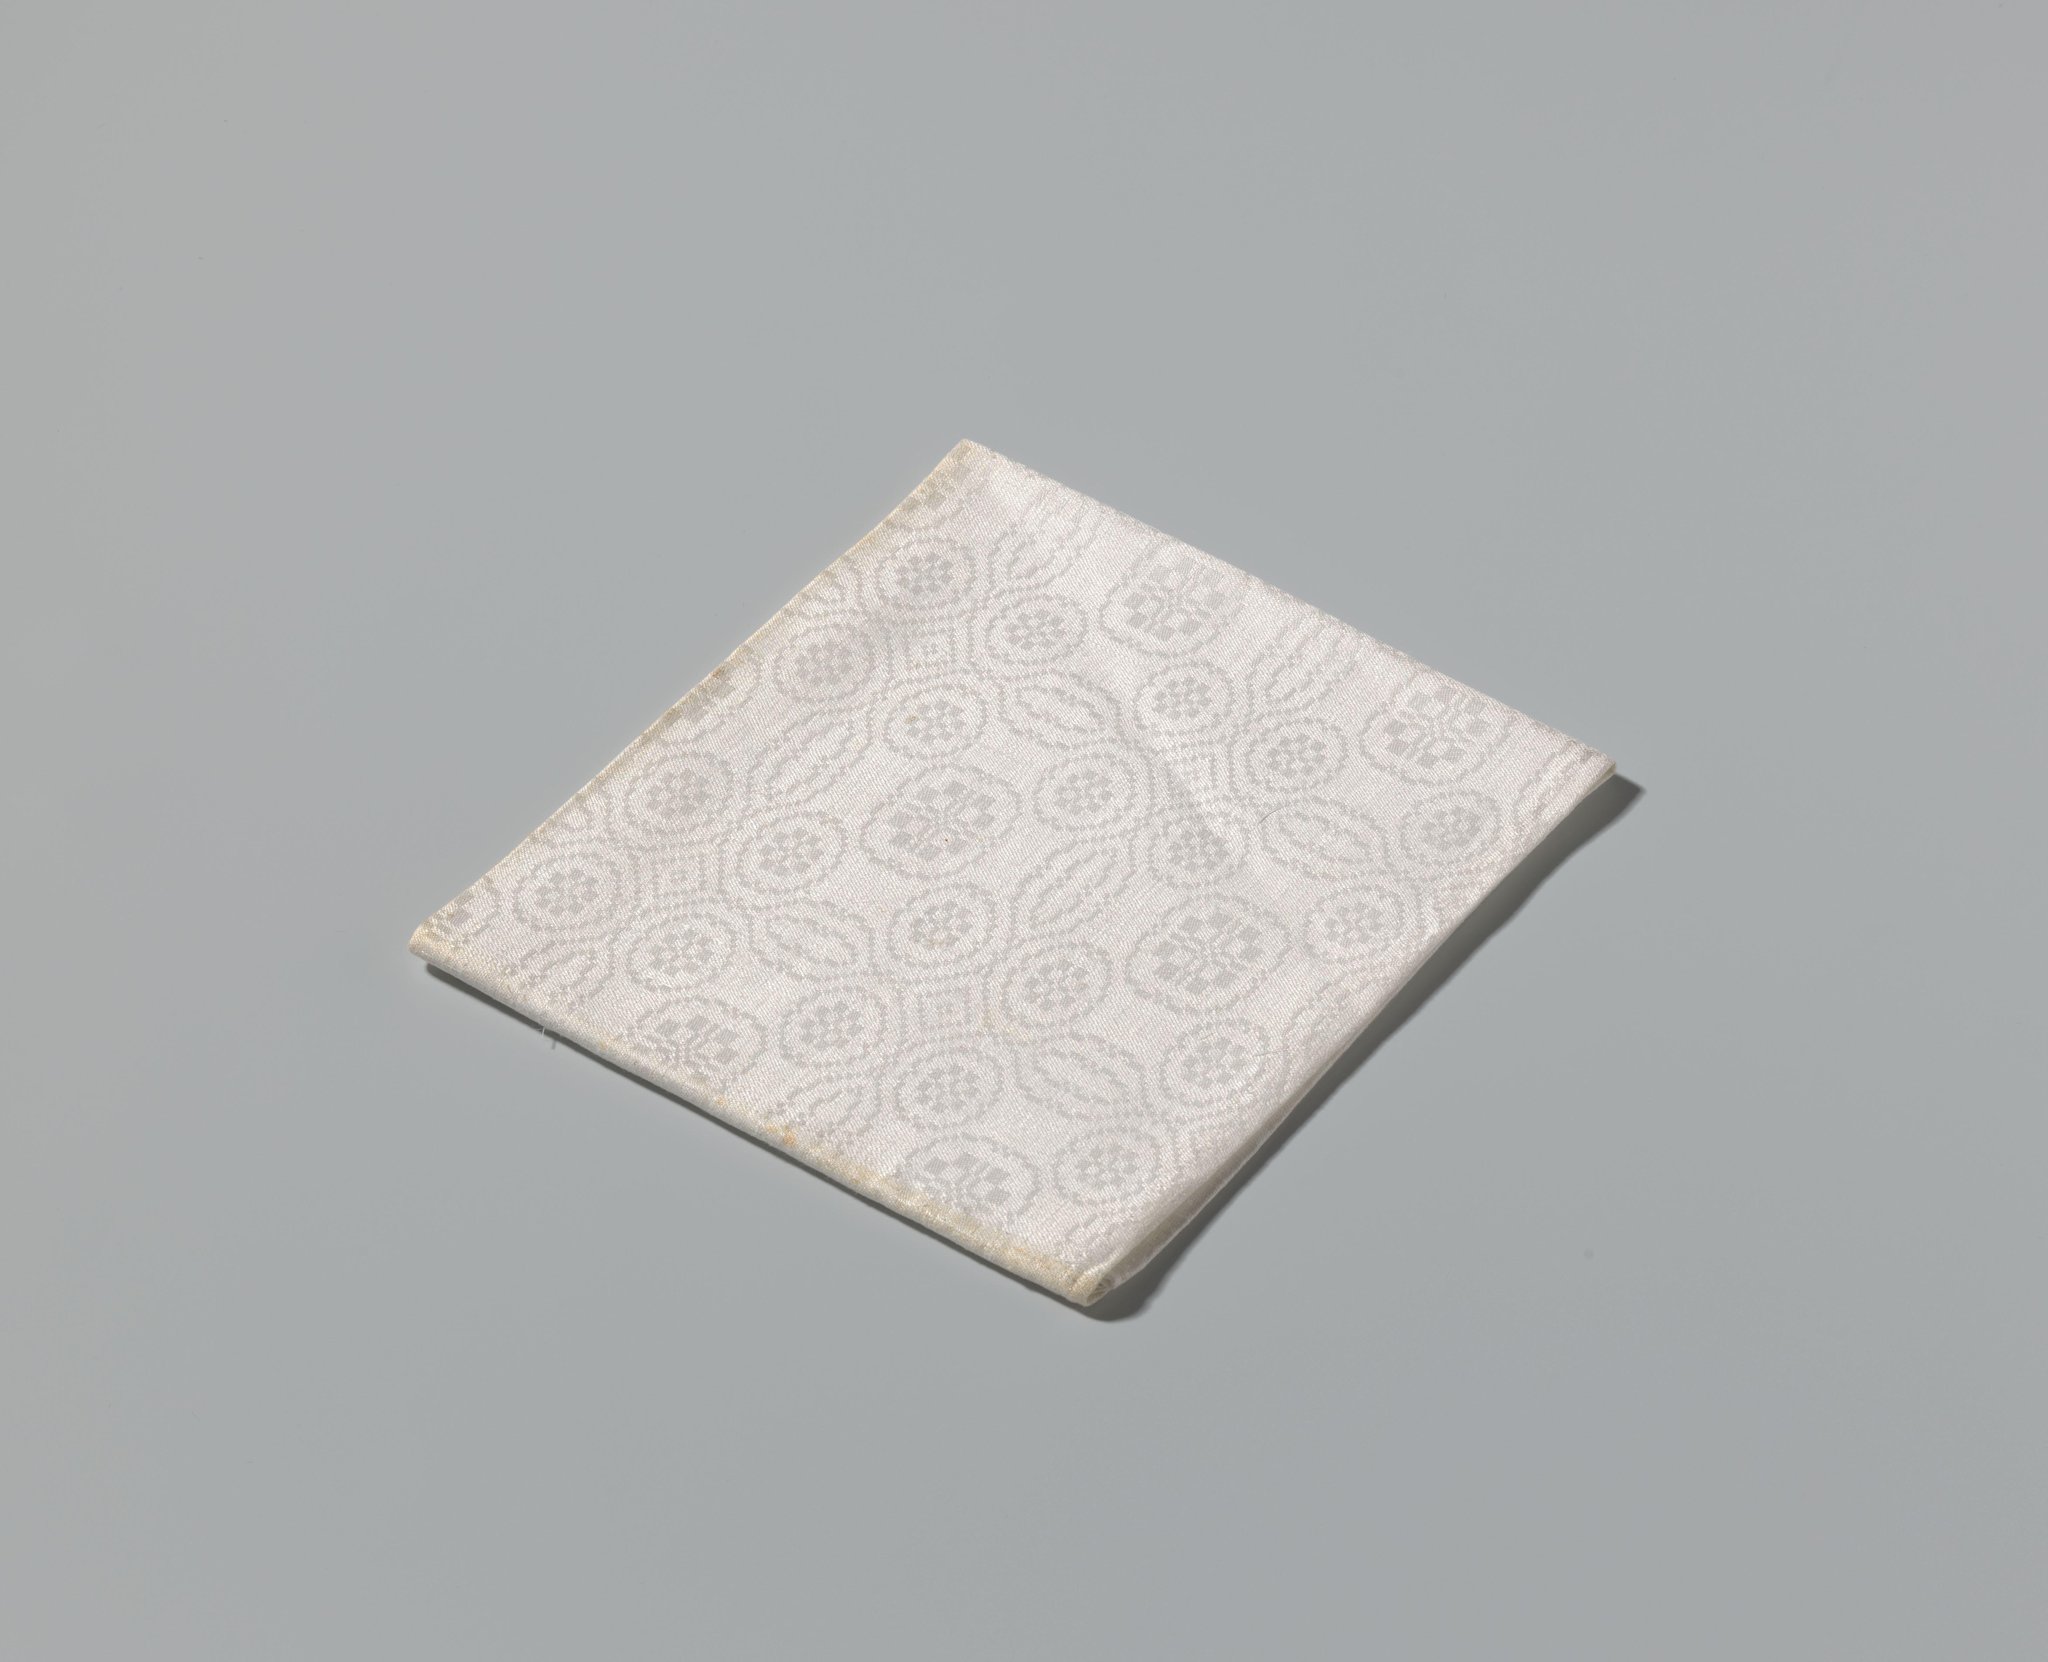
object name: napkin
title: Pellen. Merk: kroon K6WH 2oonl.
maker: Anonymous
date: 1800-1899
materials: linen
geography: netherlands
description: Servet van wit linnen met een pellen patroon, merk kroon K 6 WH 2oonl.